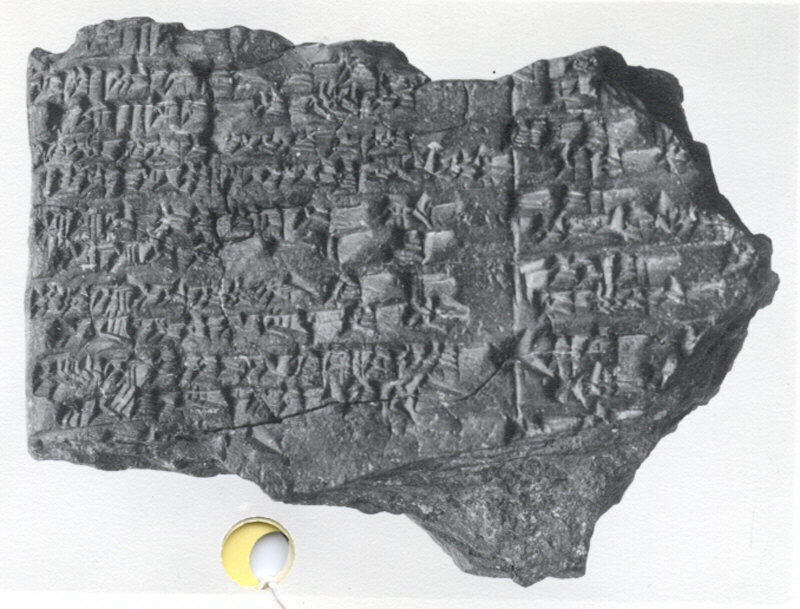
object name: cuneiform tablet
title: Cuneiform tablet: nir-gal lu e-NE, shuilla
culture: parthian or seleucid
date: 200-1 BCE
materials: clay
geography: mesopotamia